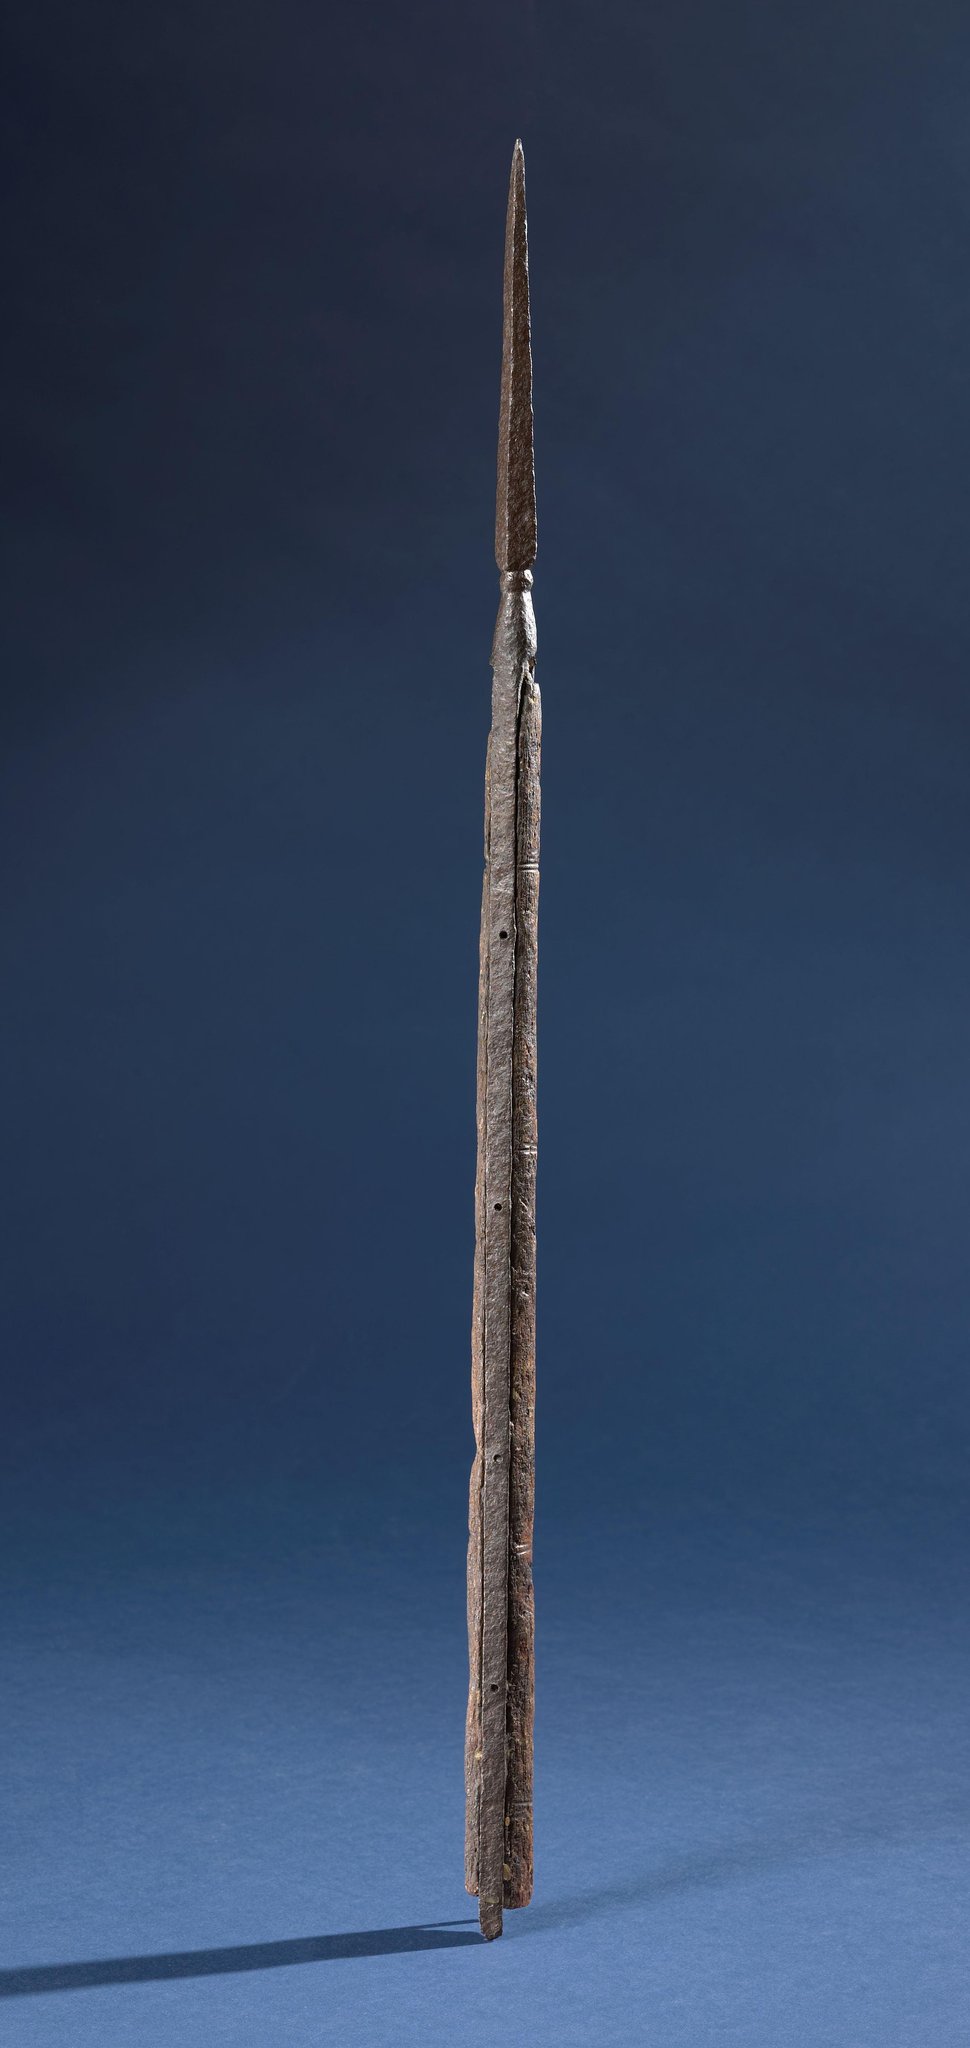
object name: pike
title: Handpiek, fragment bestaande uit kling en een gedeelte van stok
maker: Anonymous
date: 1590-1596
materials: iron, wood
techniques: cutting, forging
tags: willem barendsz., amsterdam, jacob van heemskerck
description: Handpiek, fragment bestaande uit een kling van ijzer en een gedeelte van de stok.